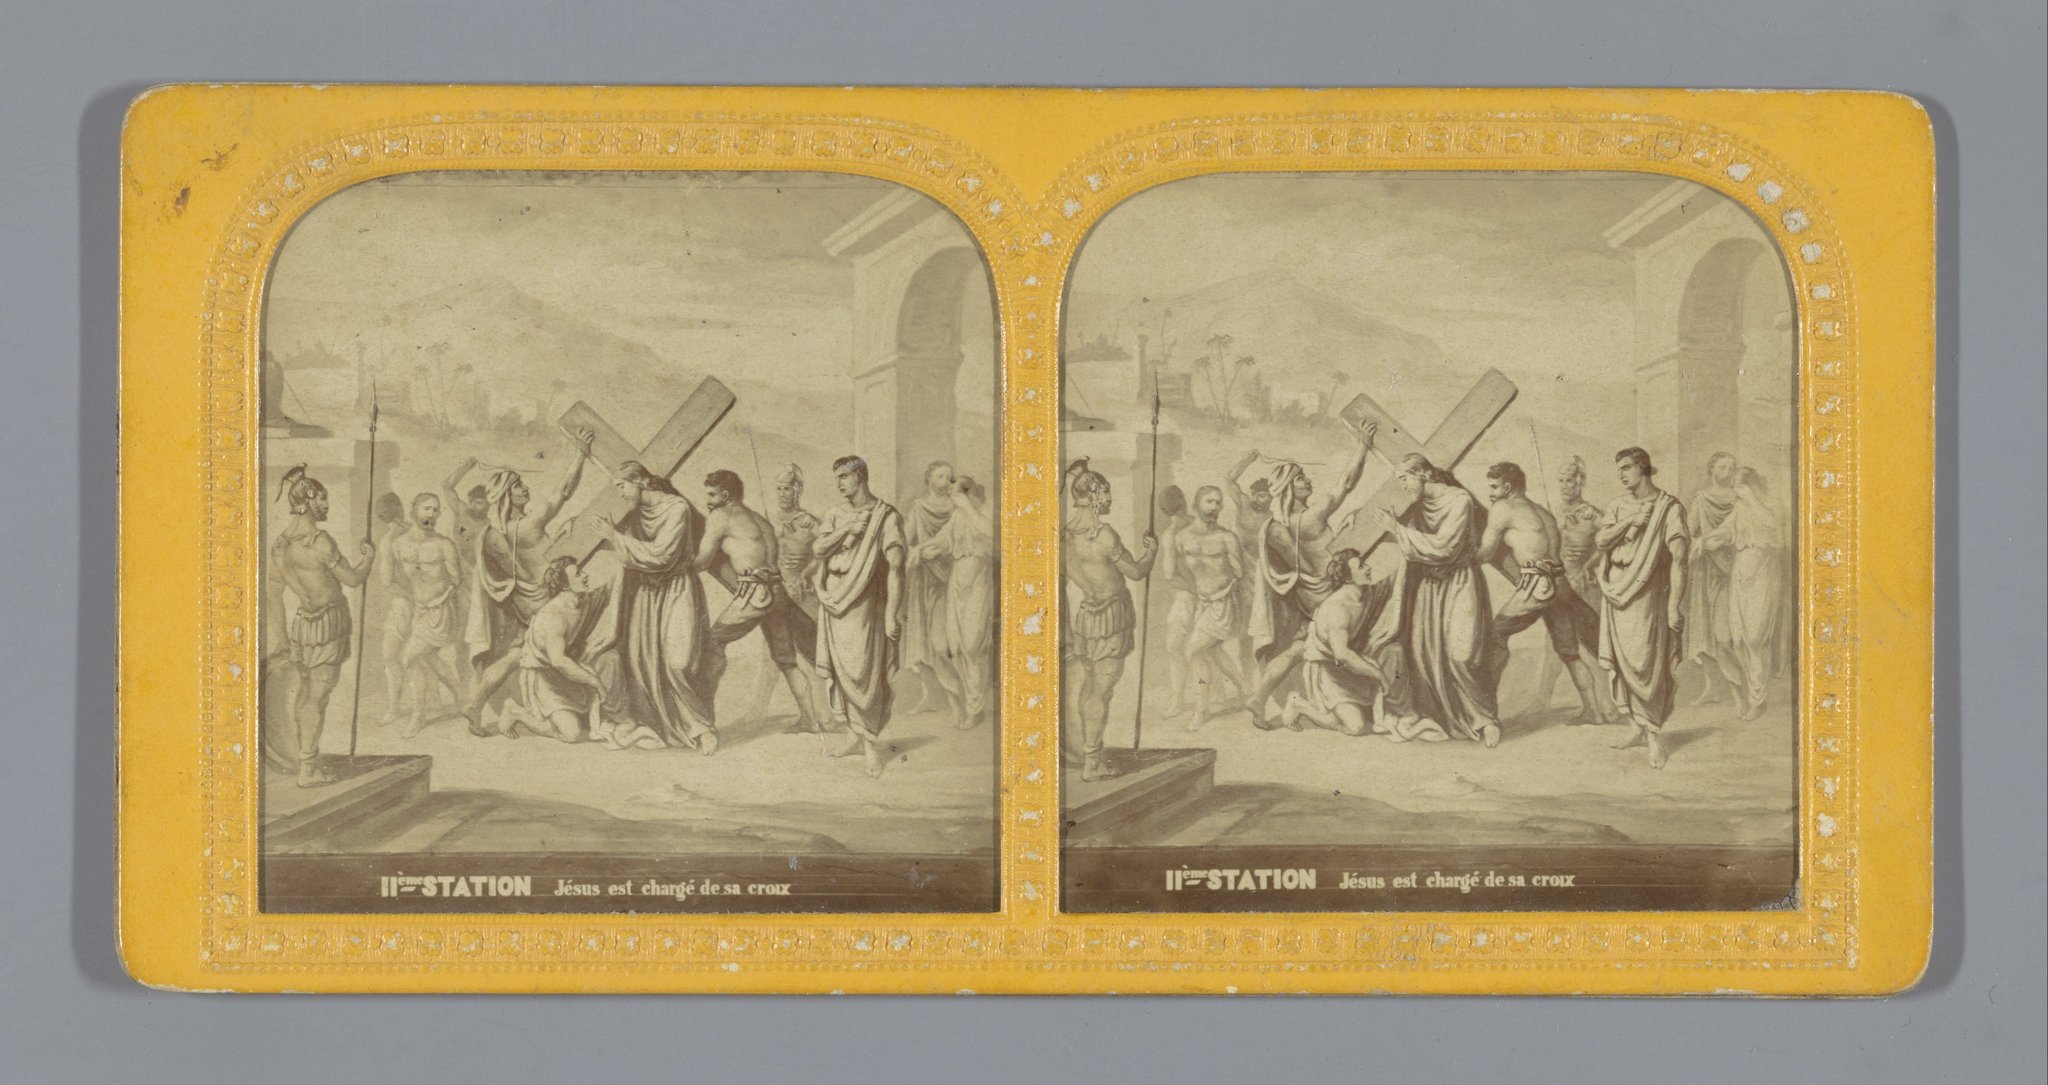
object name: tissue stereograph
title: IIème Station, Jésus est chargé de sa croix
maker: Anonymous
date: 1855-1875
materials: cardboard, paper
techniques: albumen print, hand coloring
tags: carrying of the cross: christ bearing the cross, alone or with the help of others (e.g. simon the cyrenian)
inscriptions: number: ‘050’